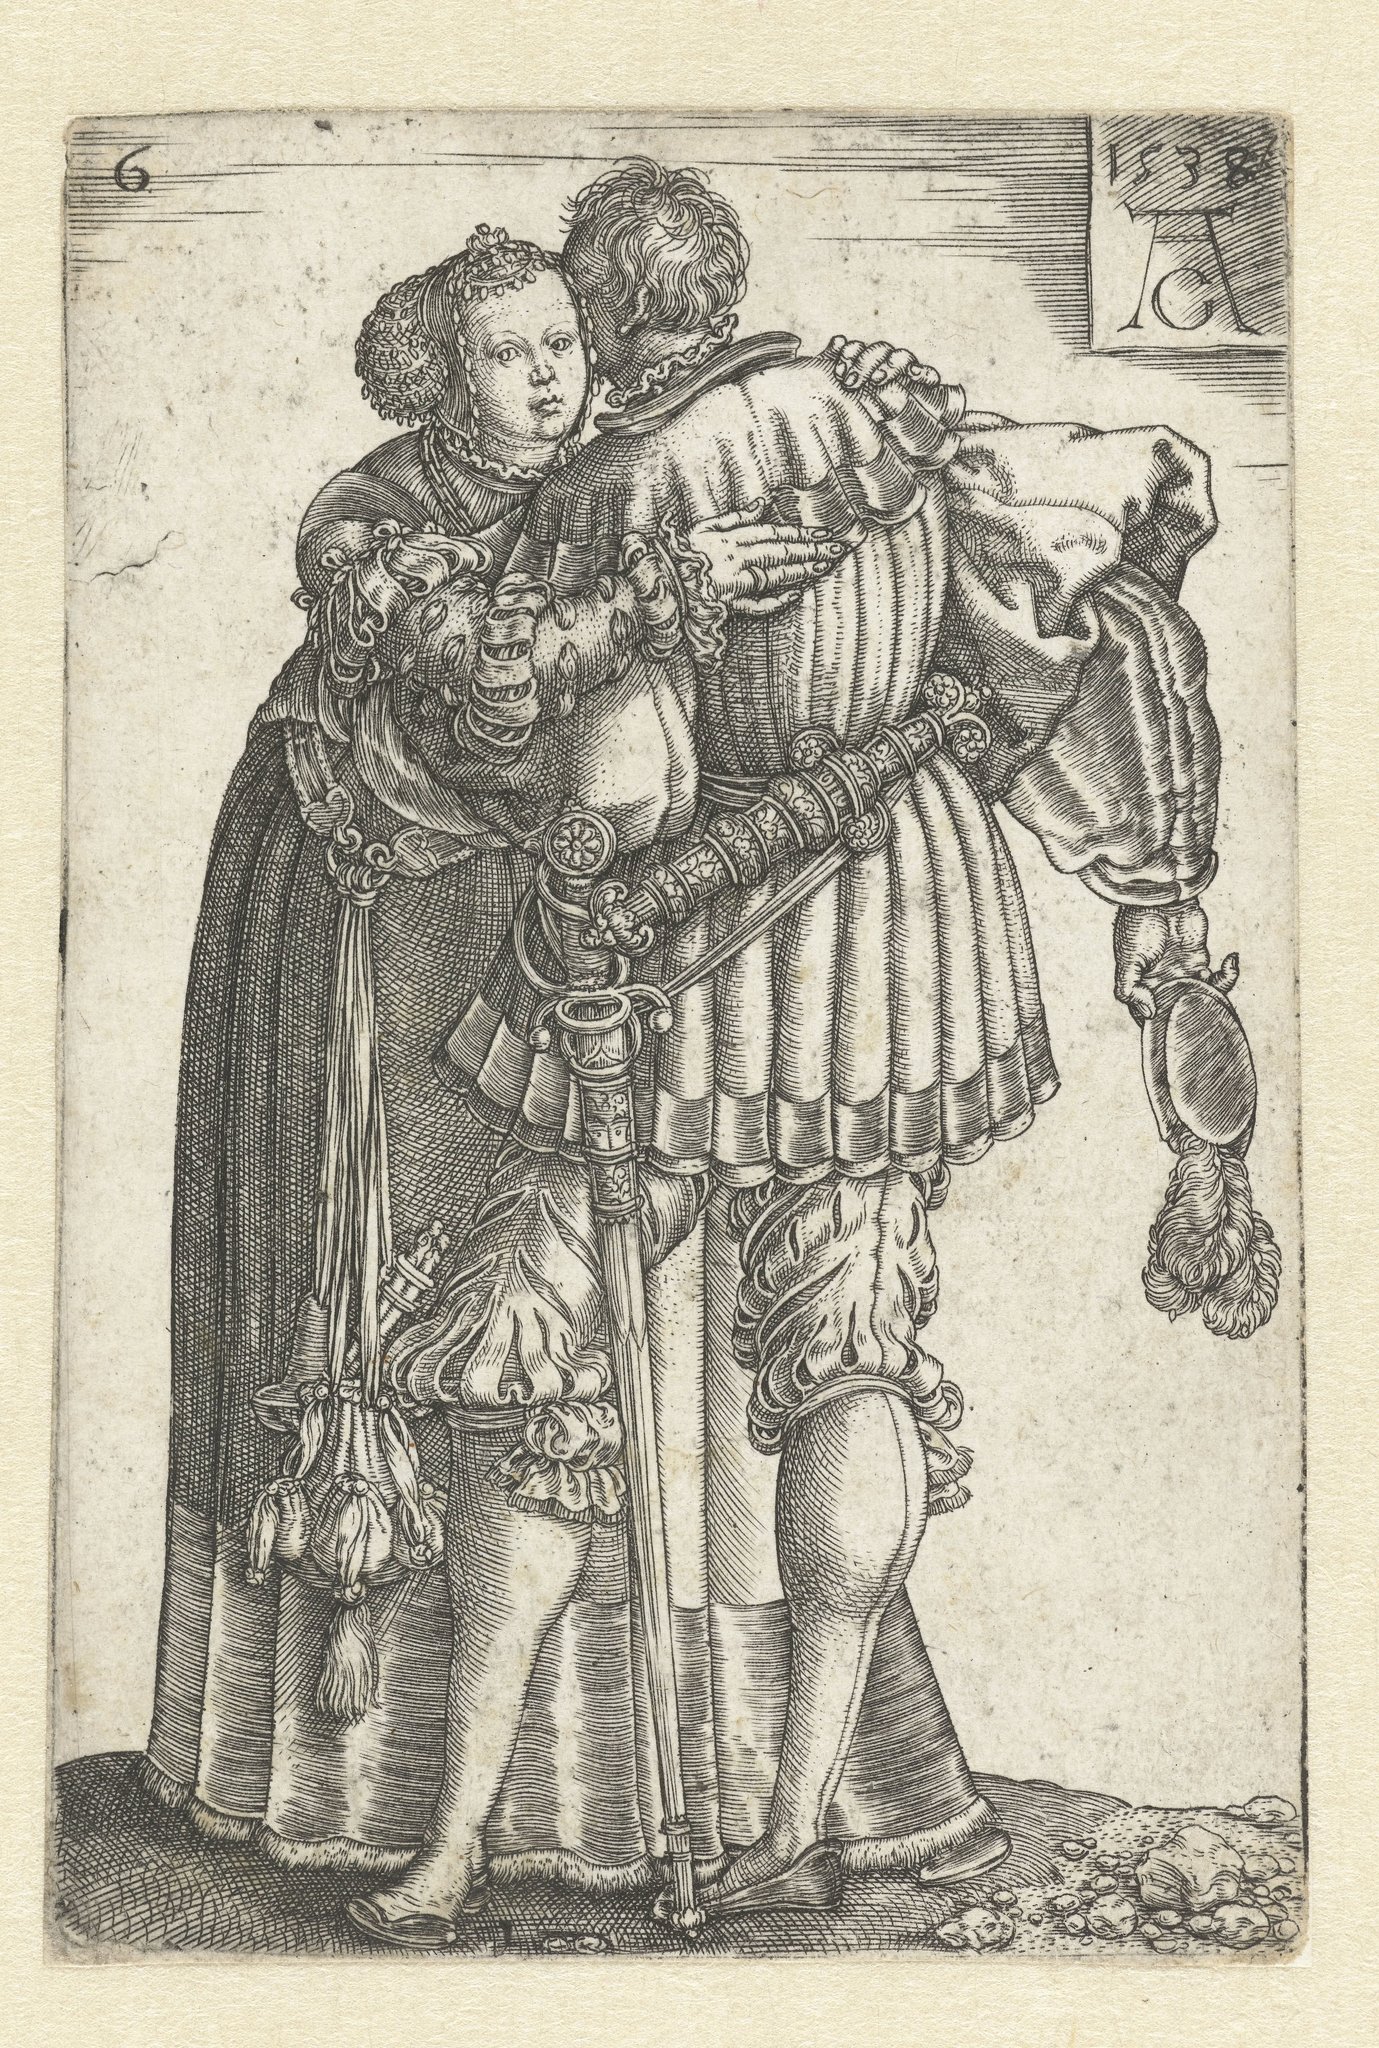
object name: print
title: Grote paren dansende bruiloftsgasten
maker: heinrich aldegrever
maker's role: draughtsman, print maker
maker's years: 1502-1561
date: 1538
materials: paper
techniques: engraving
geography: germany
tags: (lovers) embracing each other, 'symplegma', dancing at wedding feast, one pair dancing; man and woman dancing as a couple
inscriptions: collector's mark: ‘Hinloopen’ Lugt 11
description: Dansend paar. Man, op de rug gezien, wordt omhelsd door een vrouw. Hij heeft één hand op haar zij, in de andere heeft hij zijn pet vast. Zesde prent uit een serie van twaalf, vrij naar een prent van Hans Schäufelein.